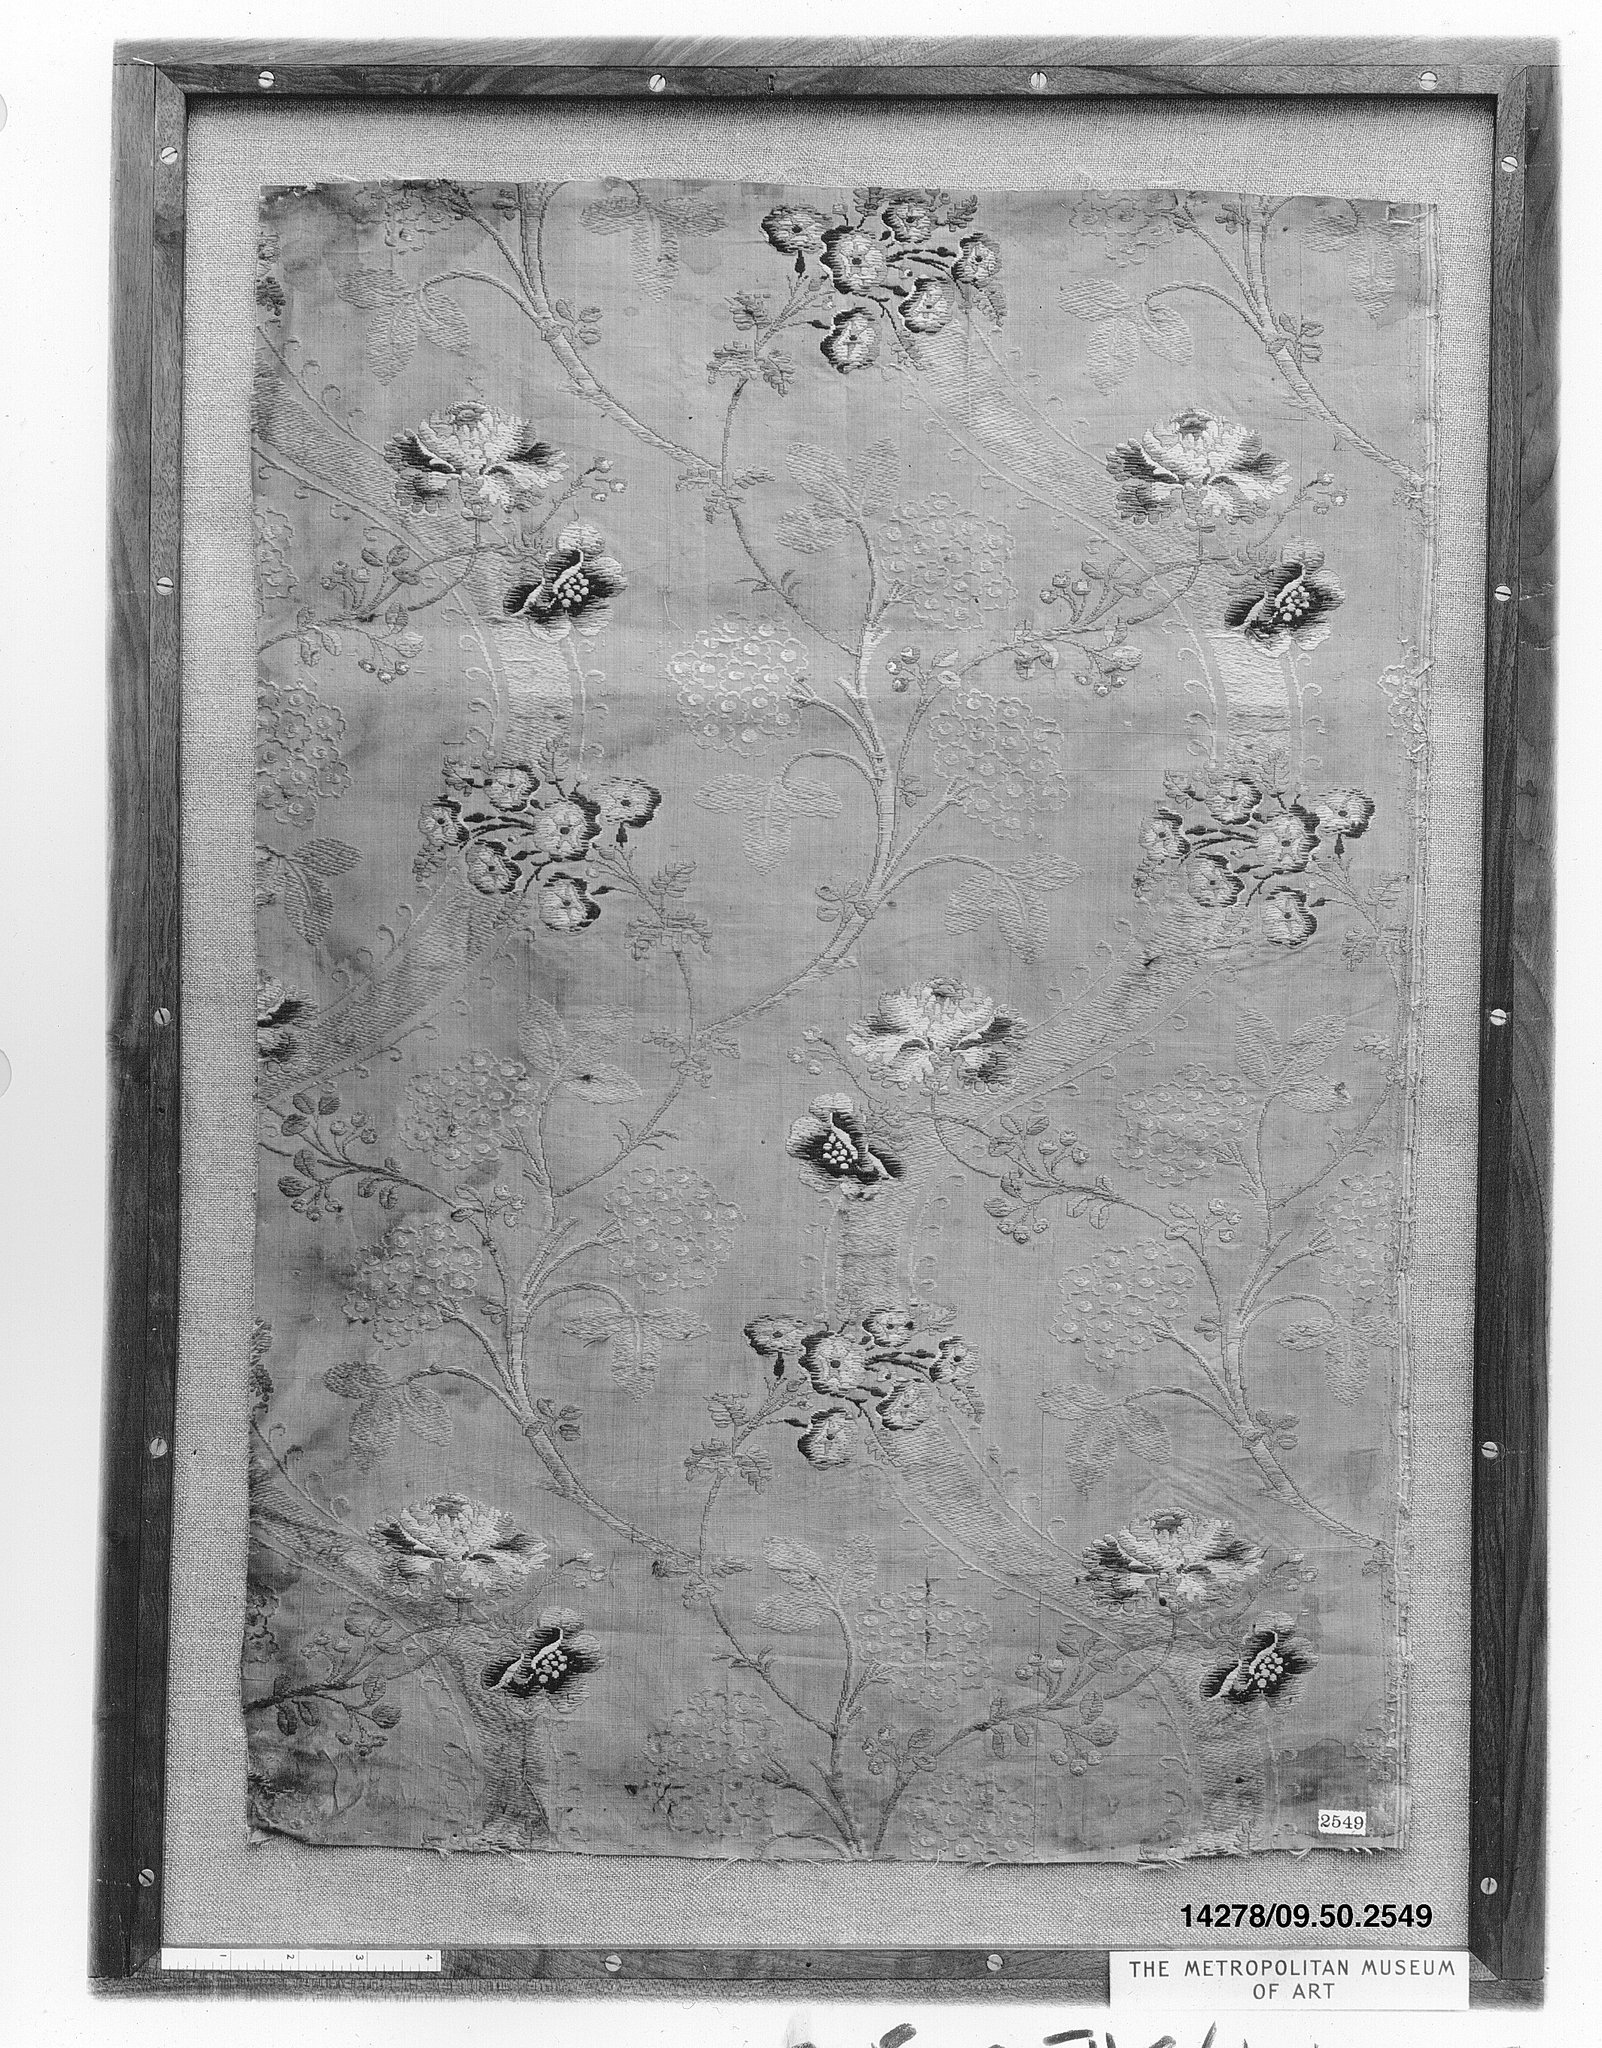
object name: piece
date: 1750-1760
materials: silk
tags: flowers,leaves